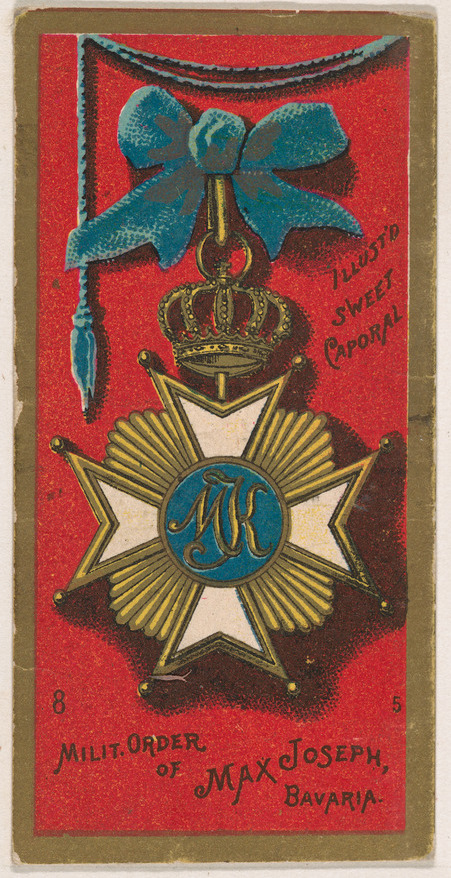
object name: print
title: Military Order of Max Joseph, Bavaria, from the Military Series (N224) issued by Kinney Tobacco Company to promote Sweet Caporal Cigarettes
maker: kinney brothers tobacco company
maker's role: publisher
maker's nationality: american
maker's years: 1869-2011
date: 1888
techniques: color lithograph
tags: insignia